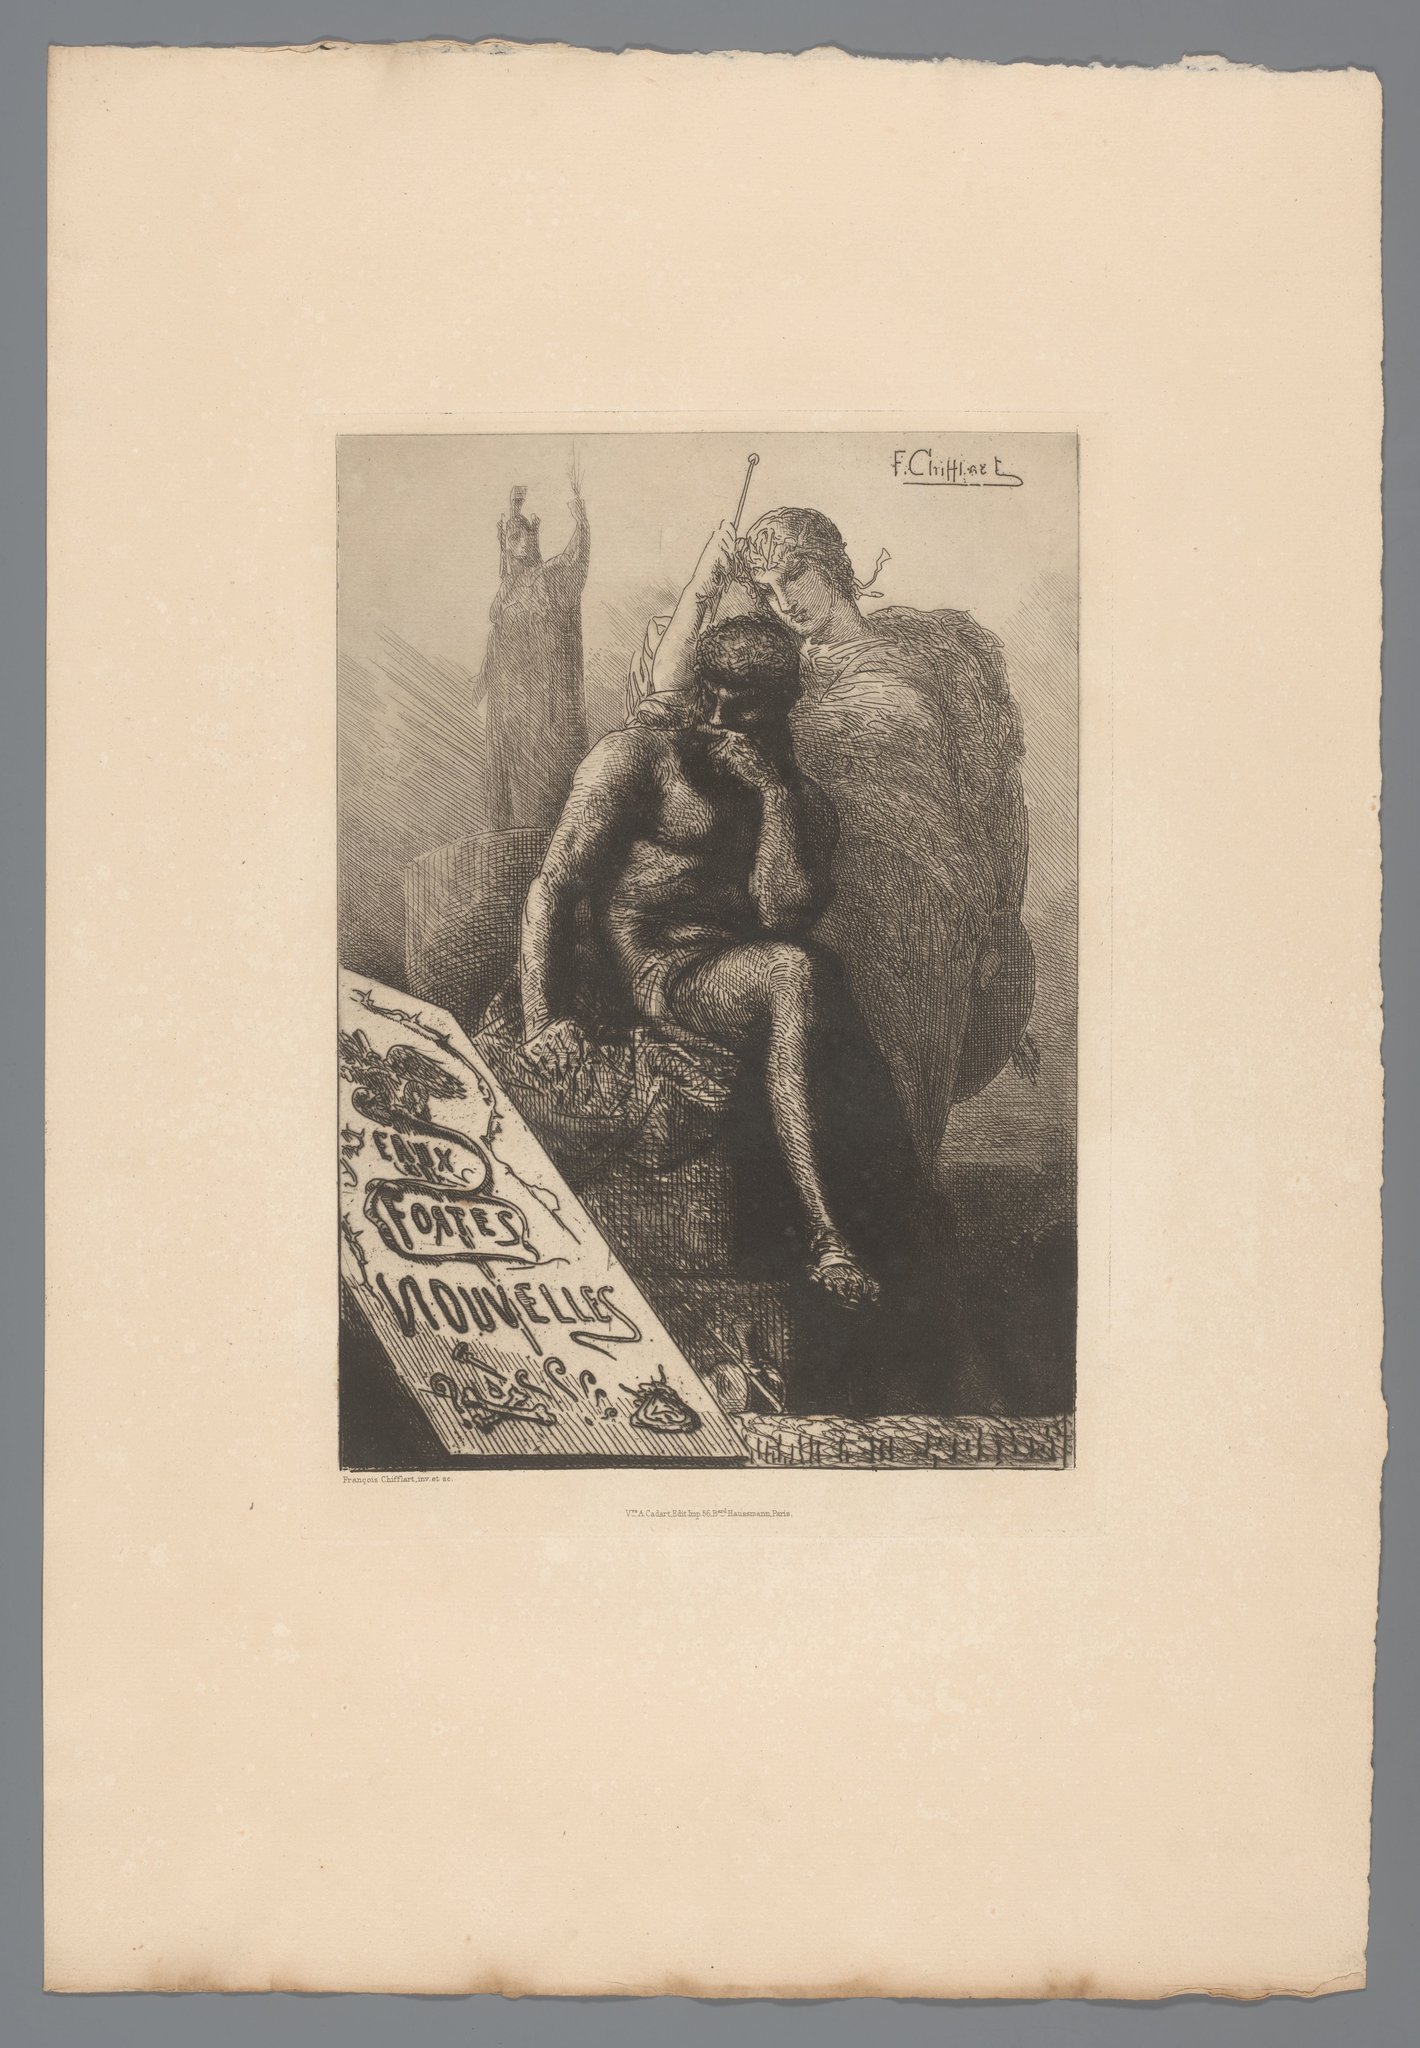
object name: titelprent, frontispice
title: Eaux Fortes Nouvelles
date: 1878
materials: paper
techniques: drypoint, etching, intaglio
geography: paris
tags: production of printed matter, book-production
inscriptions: collector's mark: Lugt 2228, watermark, collector's mark: Lugt 2760, collector's mark: ‘AFE v S’